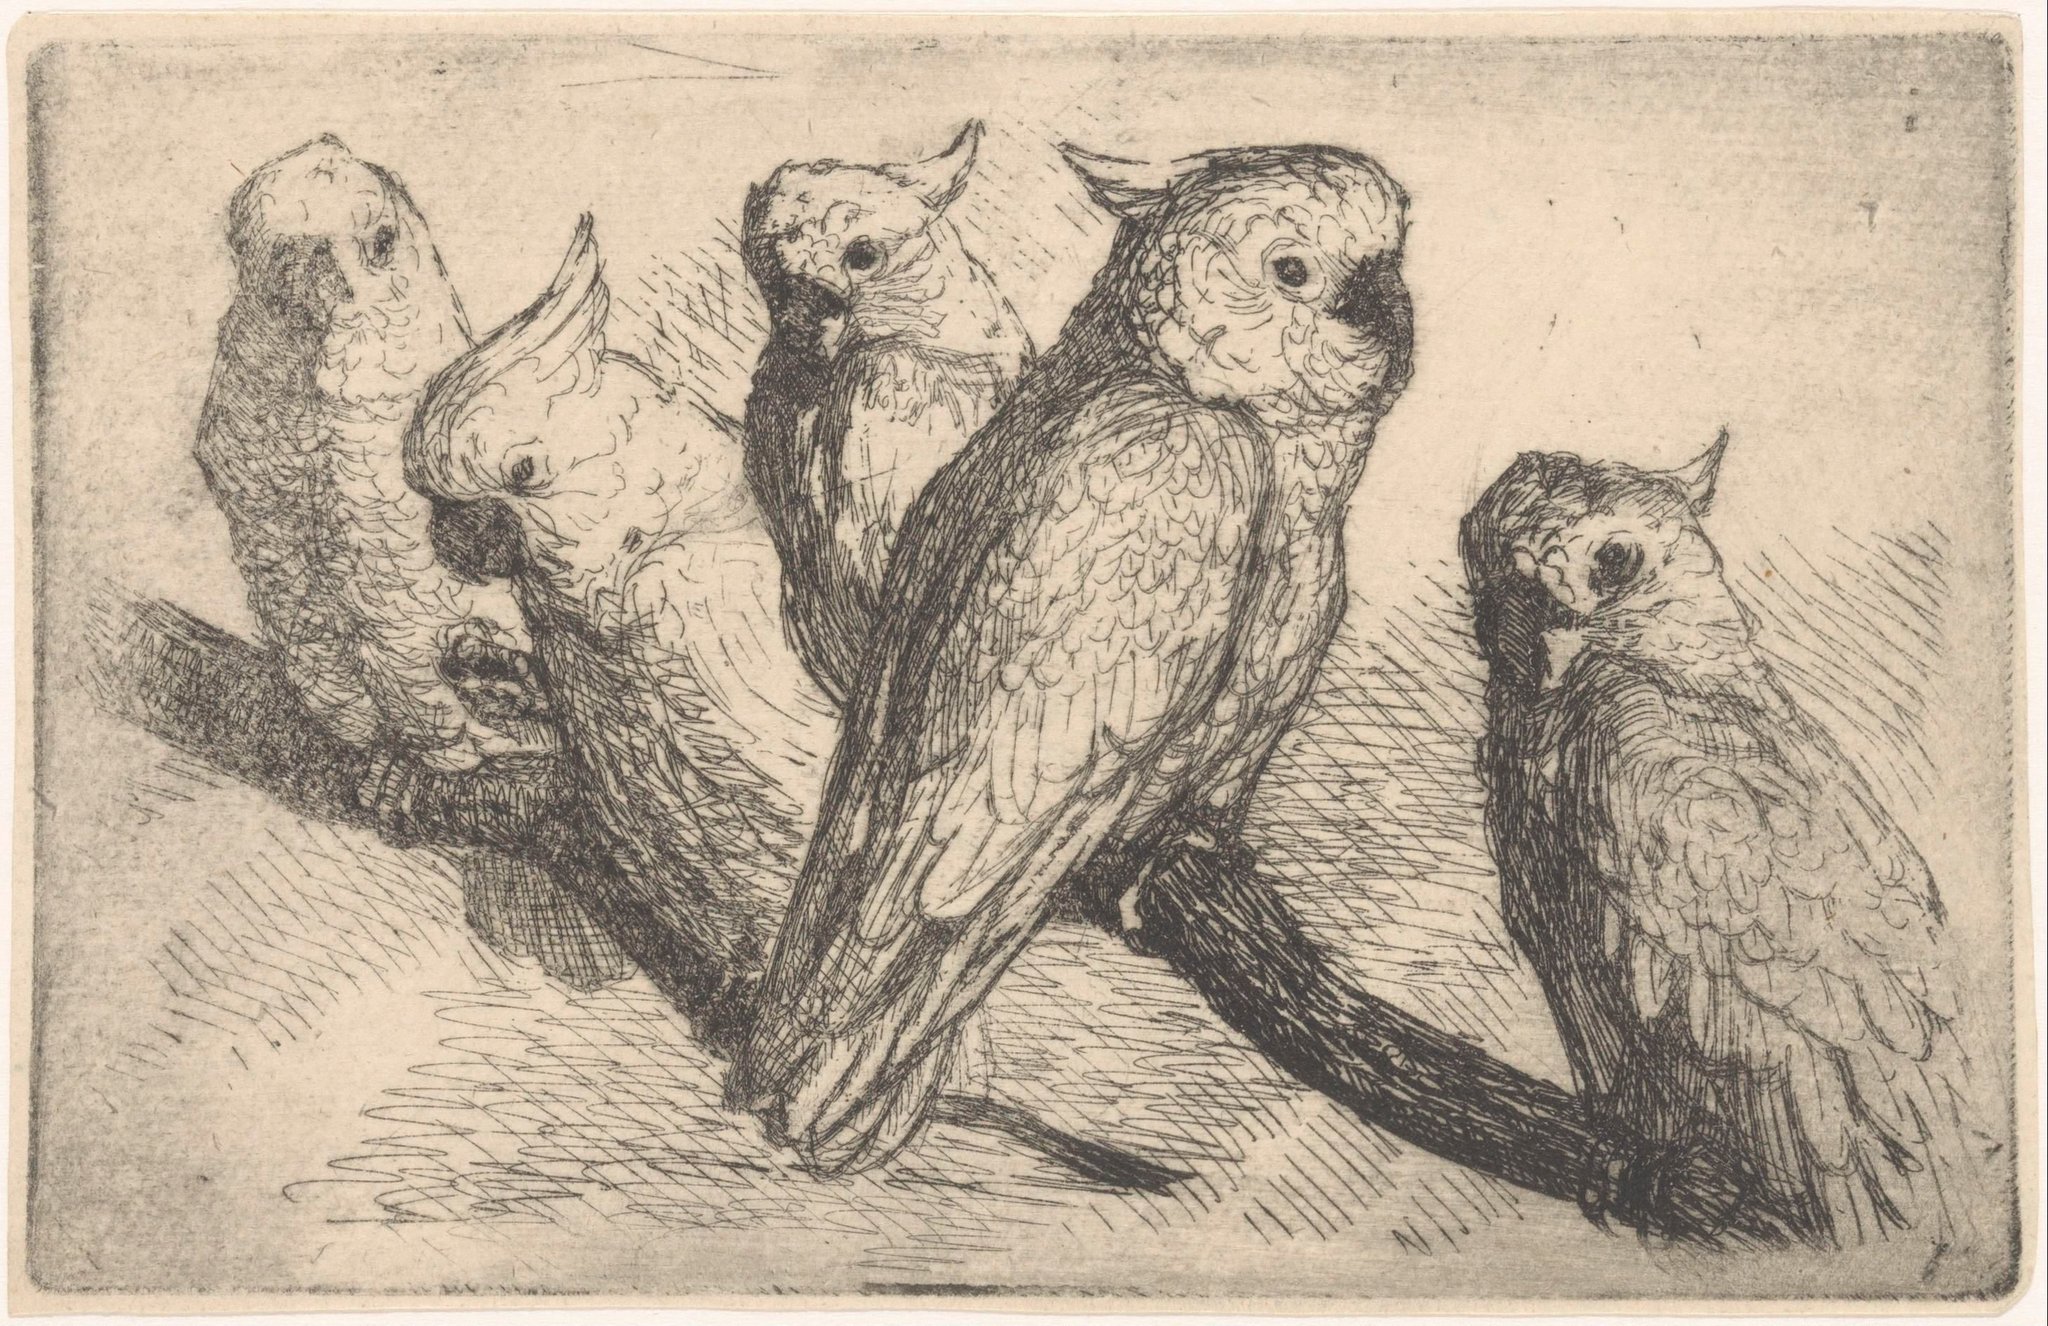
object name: print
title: Vijf kaketoes zittend op een boomtak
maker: de groot (prentmaker)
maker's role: print maker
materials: paper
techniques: etching, intaglio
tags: ornamental birds: cockatoo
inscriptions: collector's mark: Lugt 2228